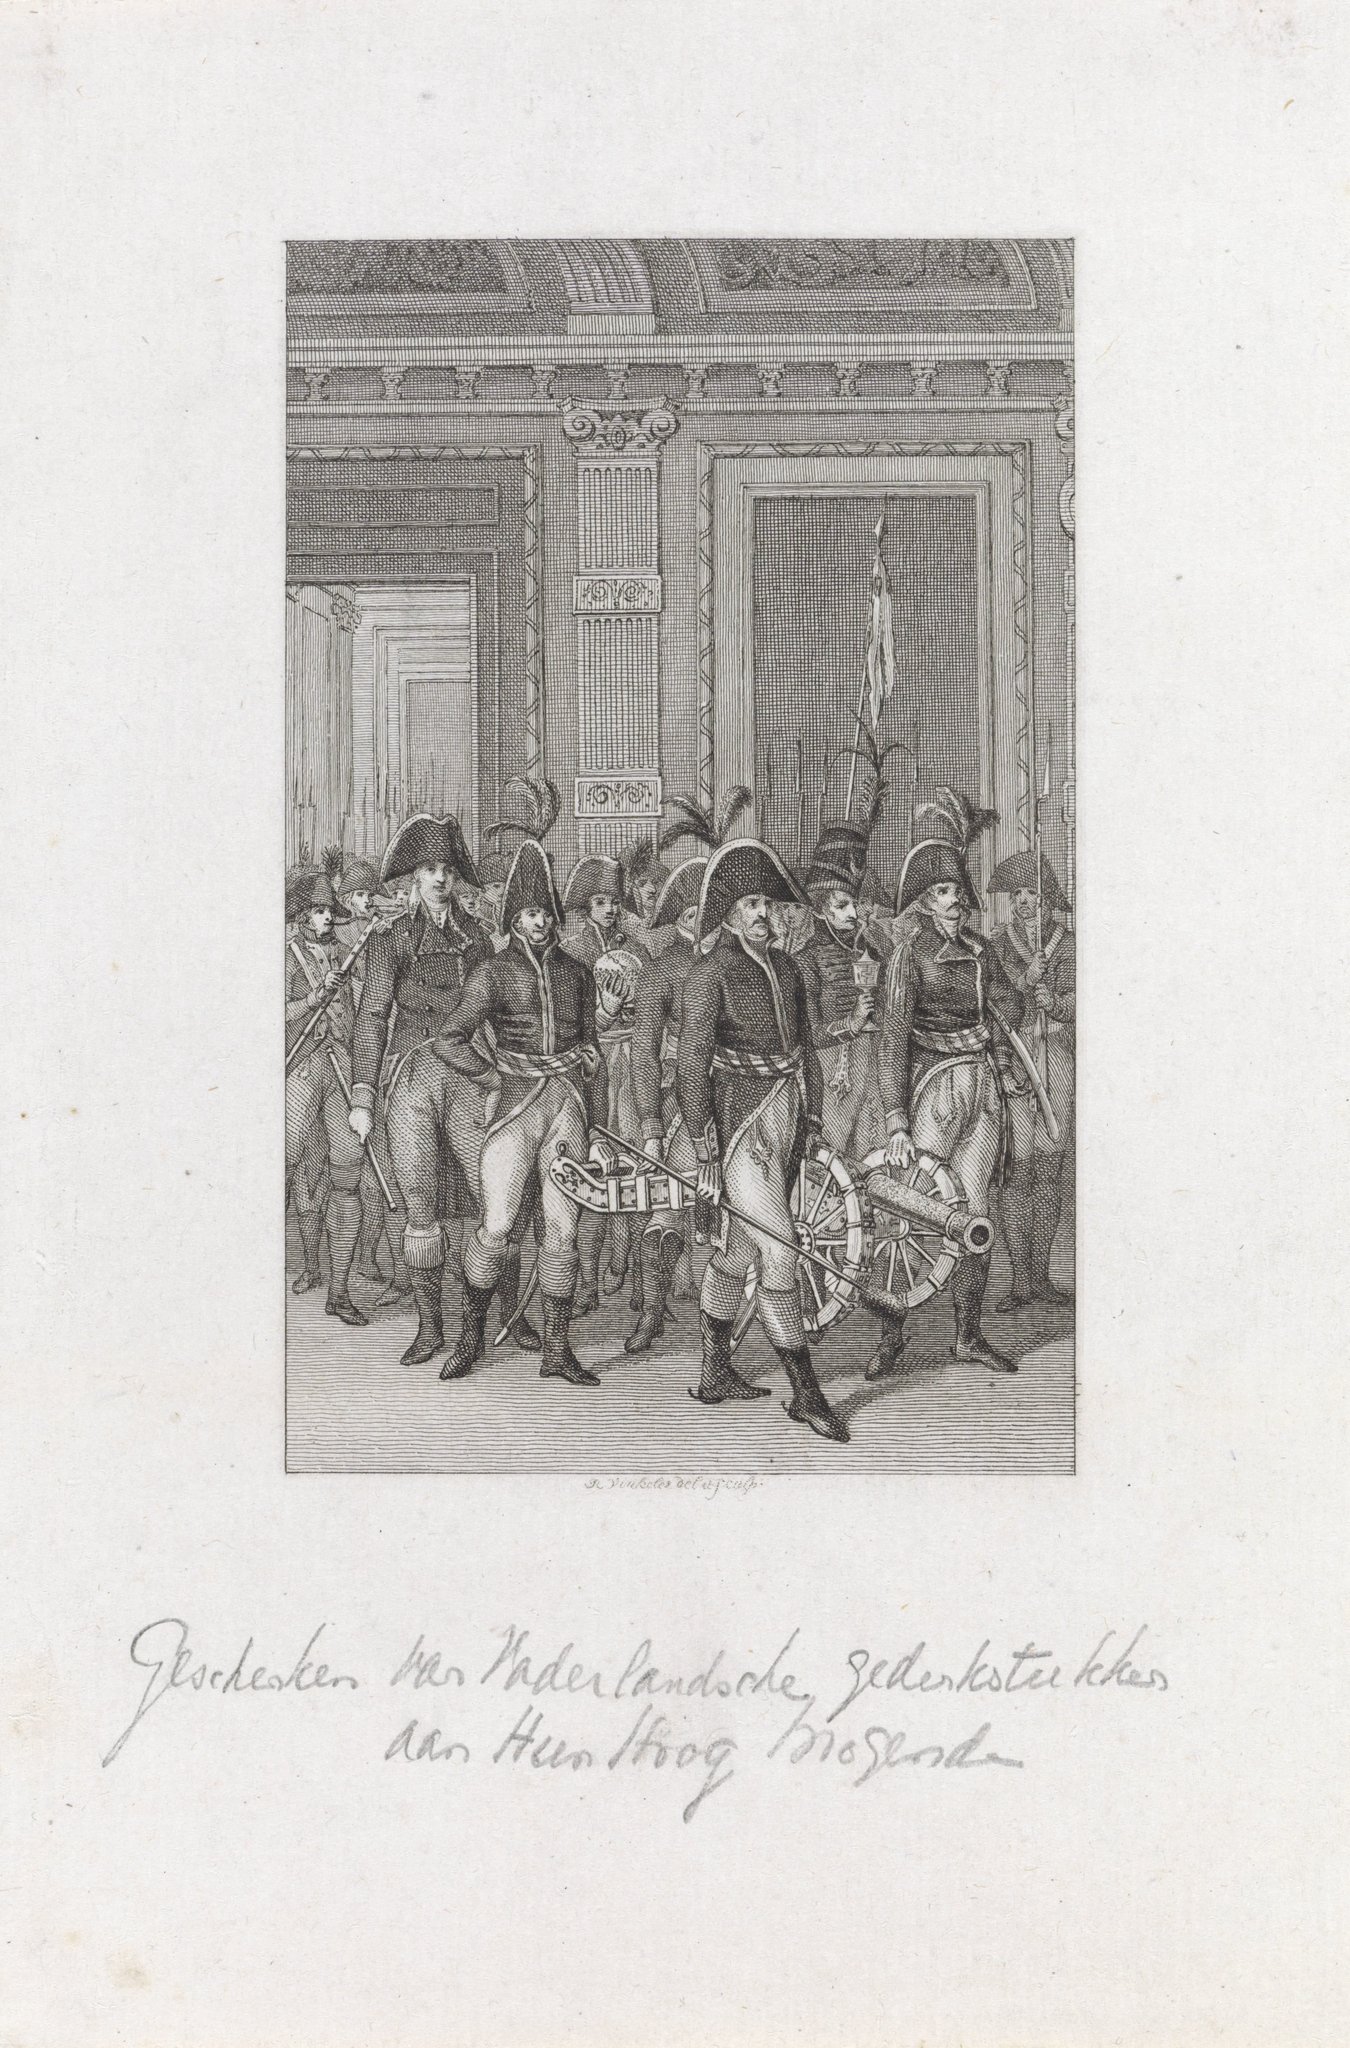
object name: history print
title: Teruggave door de Fransen van historische stukken uit stadhouderlijke collectie aan de Staten-Generaal, 1795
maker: reinier vinkeles (i)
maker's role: draughtsman, print maker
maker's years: 1741-1816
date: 1801-1803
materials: paper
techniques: engraving, etching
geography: amsterdam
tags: the hague, william v (prince of orange), rijksmuseum amsterdam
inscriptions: collector's mark: Lugt 2228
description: Latere staat van prent ook gebruikt in: Loosjes, P.A. Vaderlandsche historie, vervattende de geschiedenissen der Vereenigde Nederlanden […] Ten vervolge van Wagenaars Vaderlandsche historie. 48 delen. Amsterdam: Johannes Allart, 1786-1811, dl. 30 (1803), tussen p. 304 en 305. Voor de geretourneerde stukken zie: NG-NM-1015 en NG-NM-878-A.